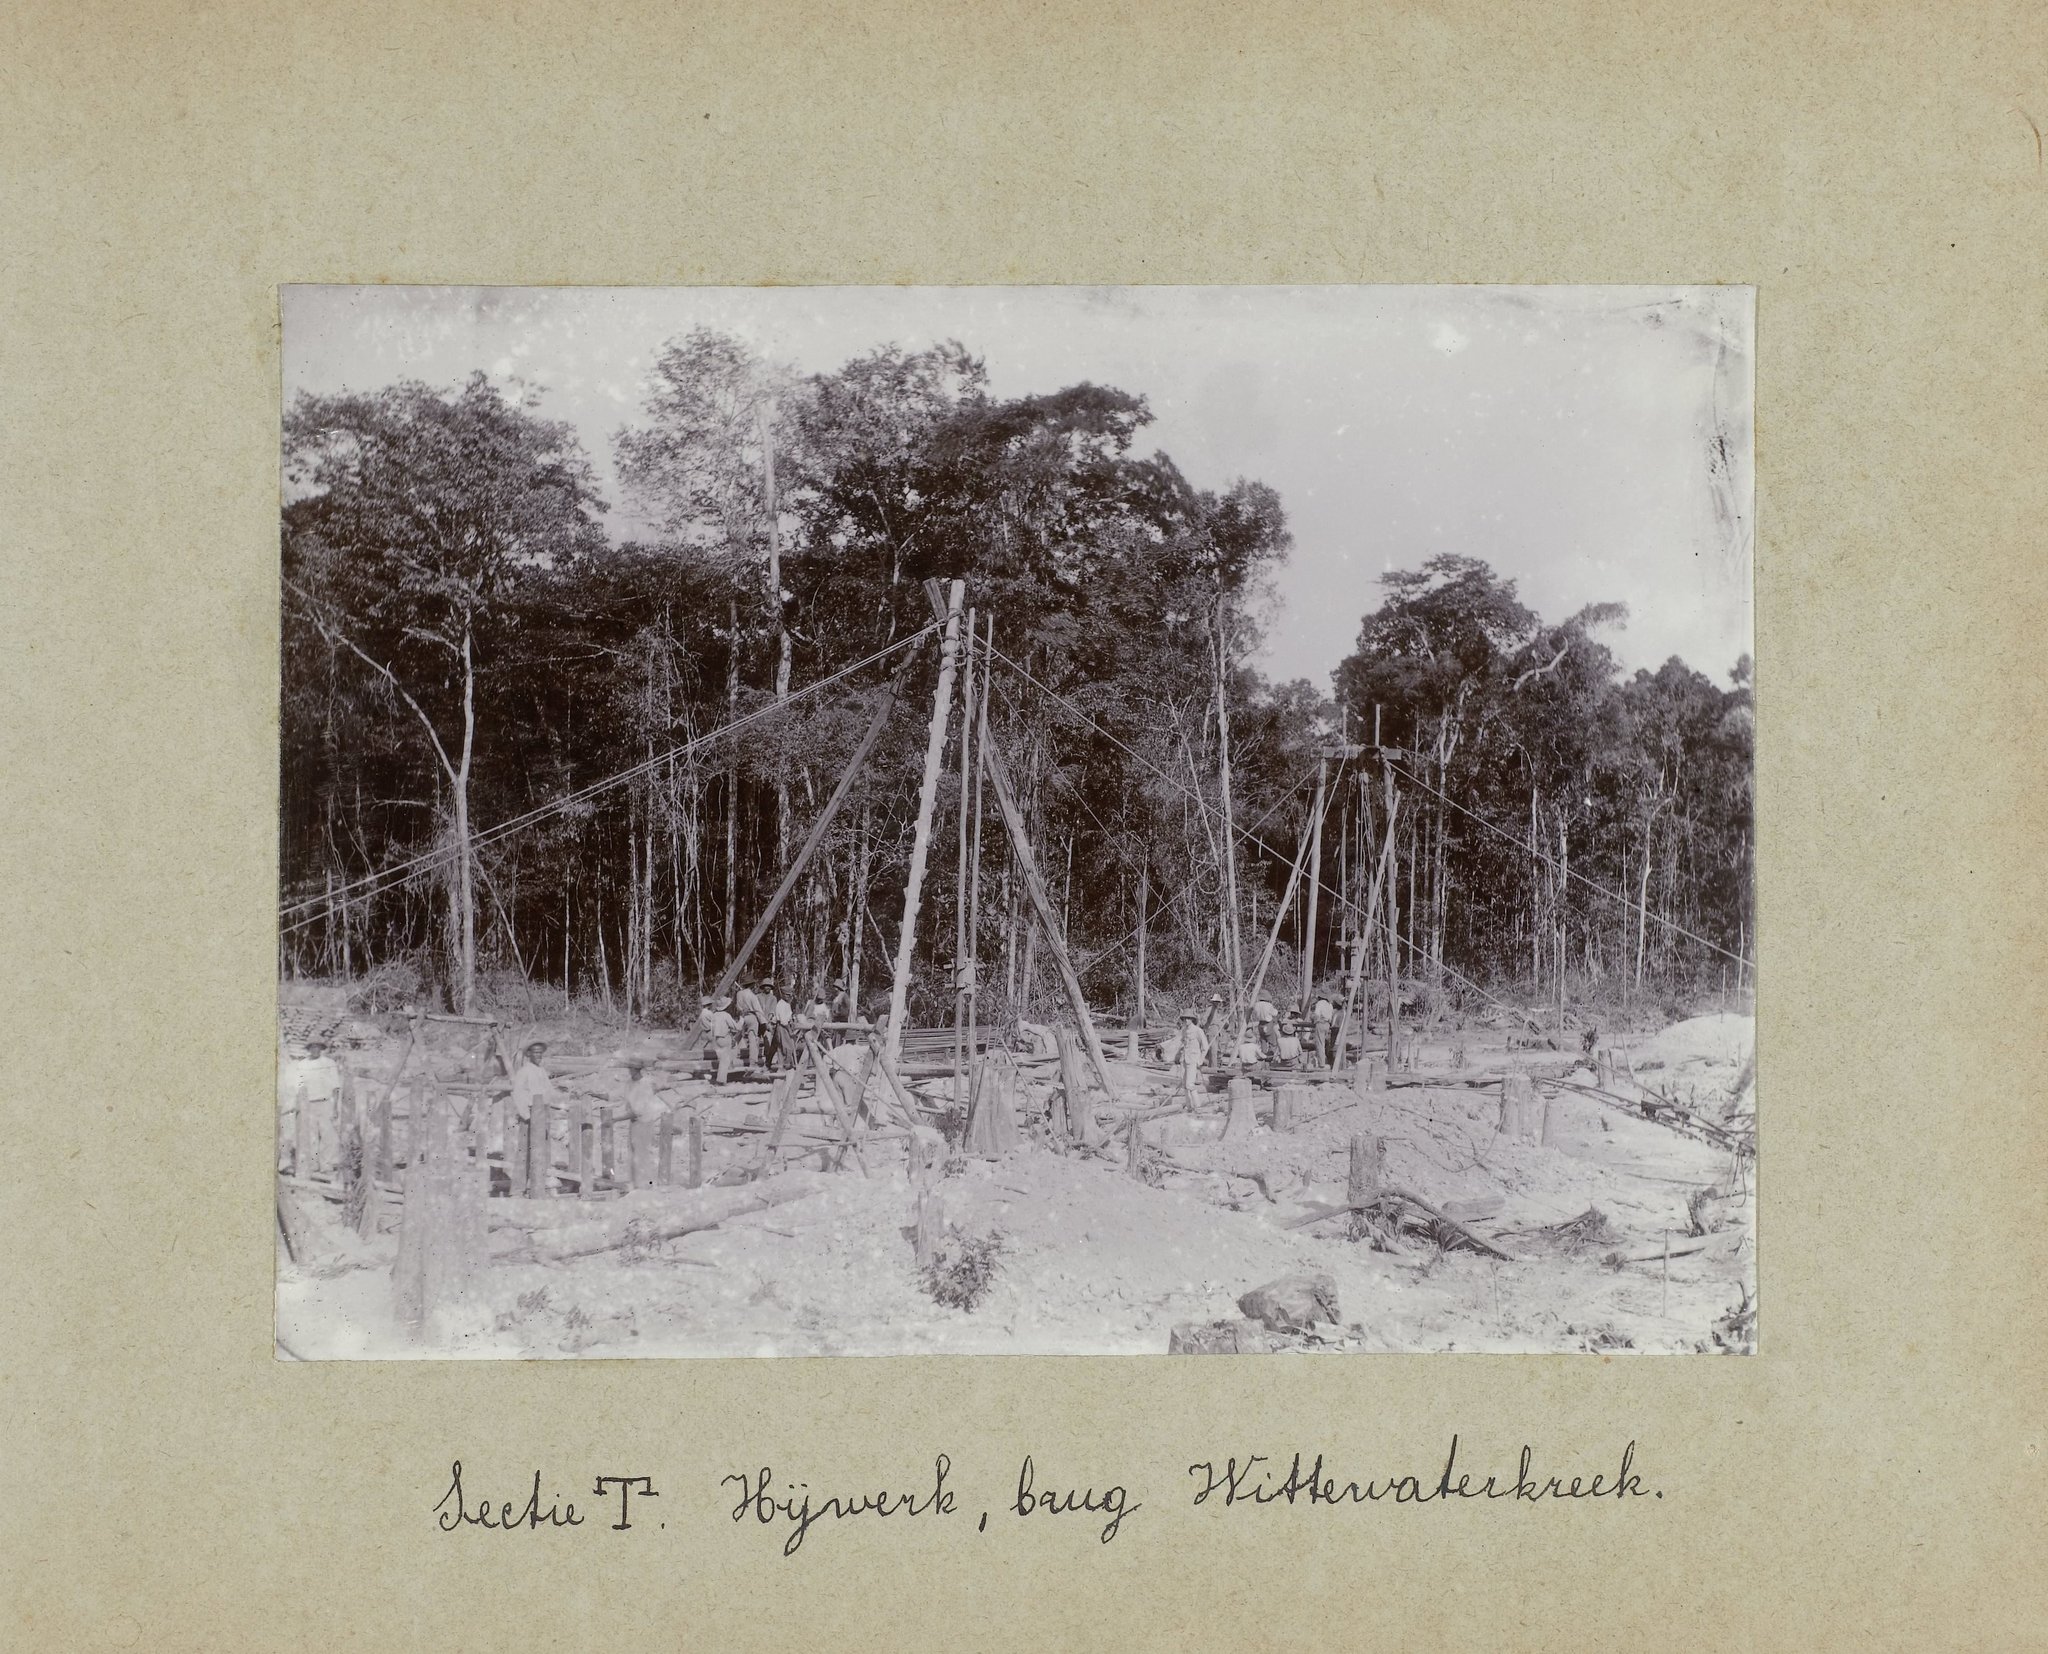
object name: photograph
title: Sectie T. Hijwerk, brug Wittewaterkreek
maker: augusta curiel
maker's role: fotograaf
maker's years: 1873-1937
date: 1905-1910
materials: photographic support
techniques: photography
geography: suriname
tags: jacob evert wesenhagen, railway, tramway; rack railway, suriname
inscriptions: inscription: ‘Sectie T. Hijwerk, brug Wittewaterkreek’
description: Heiwerk voor de aanleg van de brug over de Wittewater kreek (Wittiewatra) Foto in het fotoalbum over de aanleg van de Lawaspoorweg in Suriname in de jaren 1903-1912. Onderdeel van een groep objecten afkomstig van de familie Wesenhagen in Suriname.